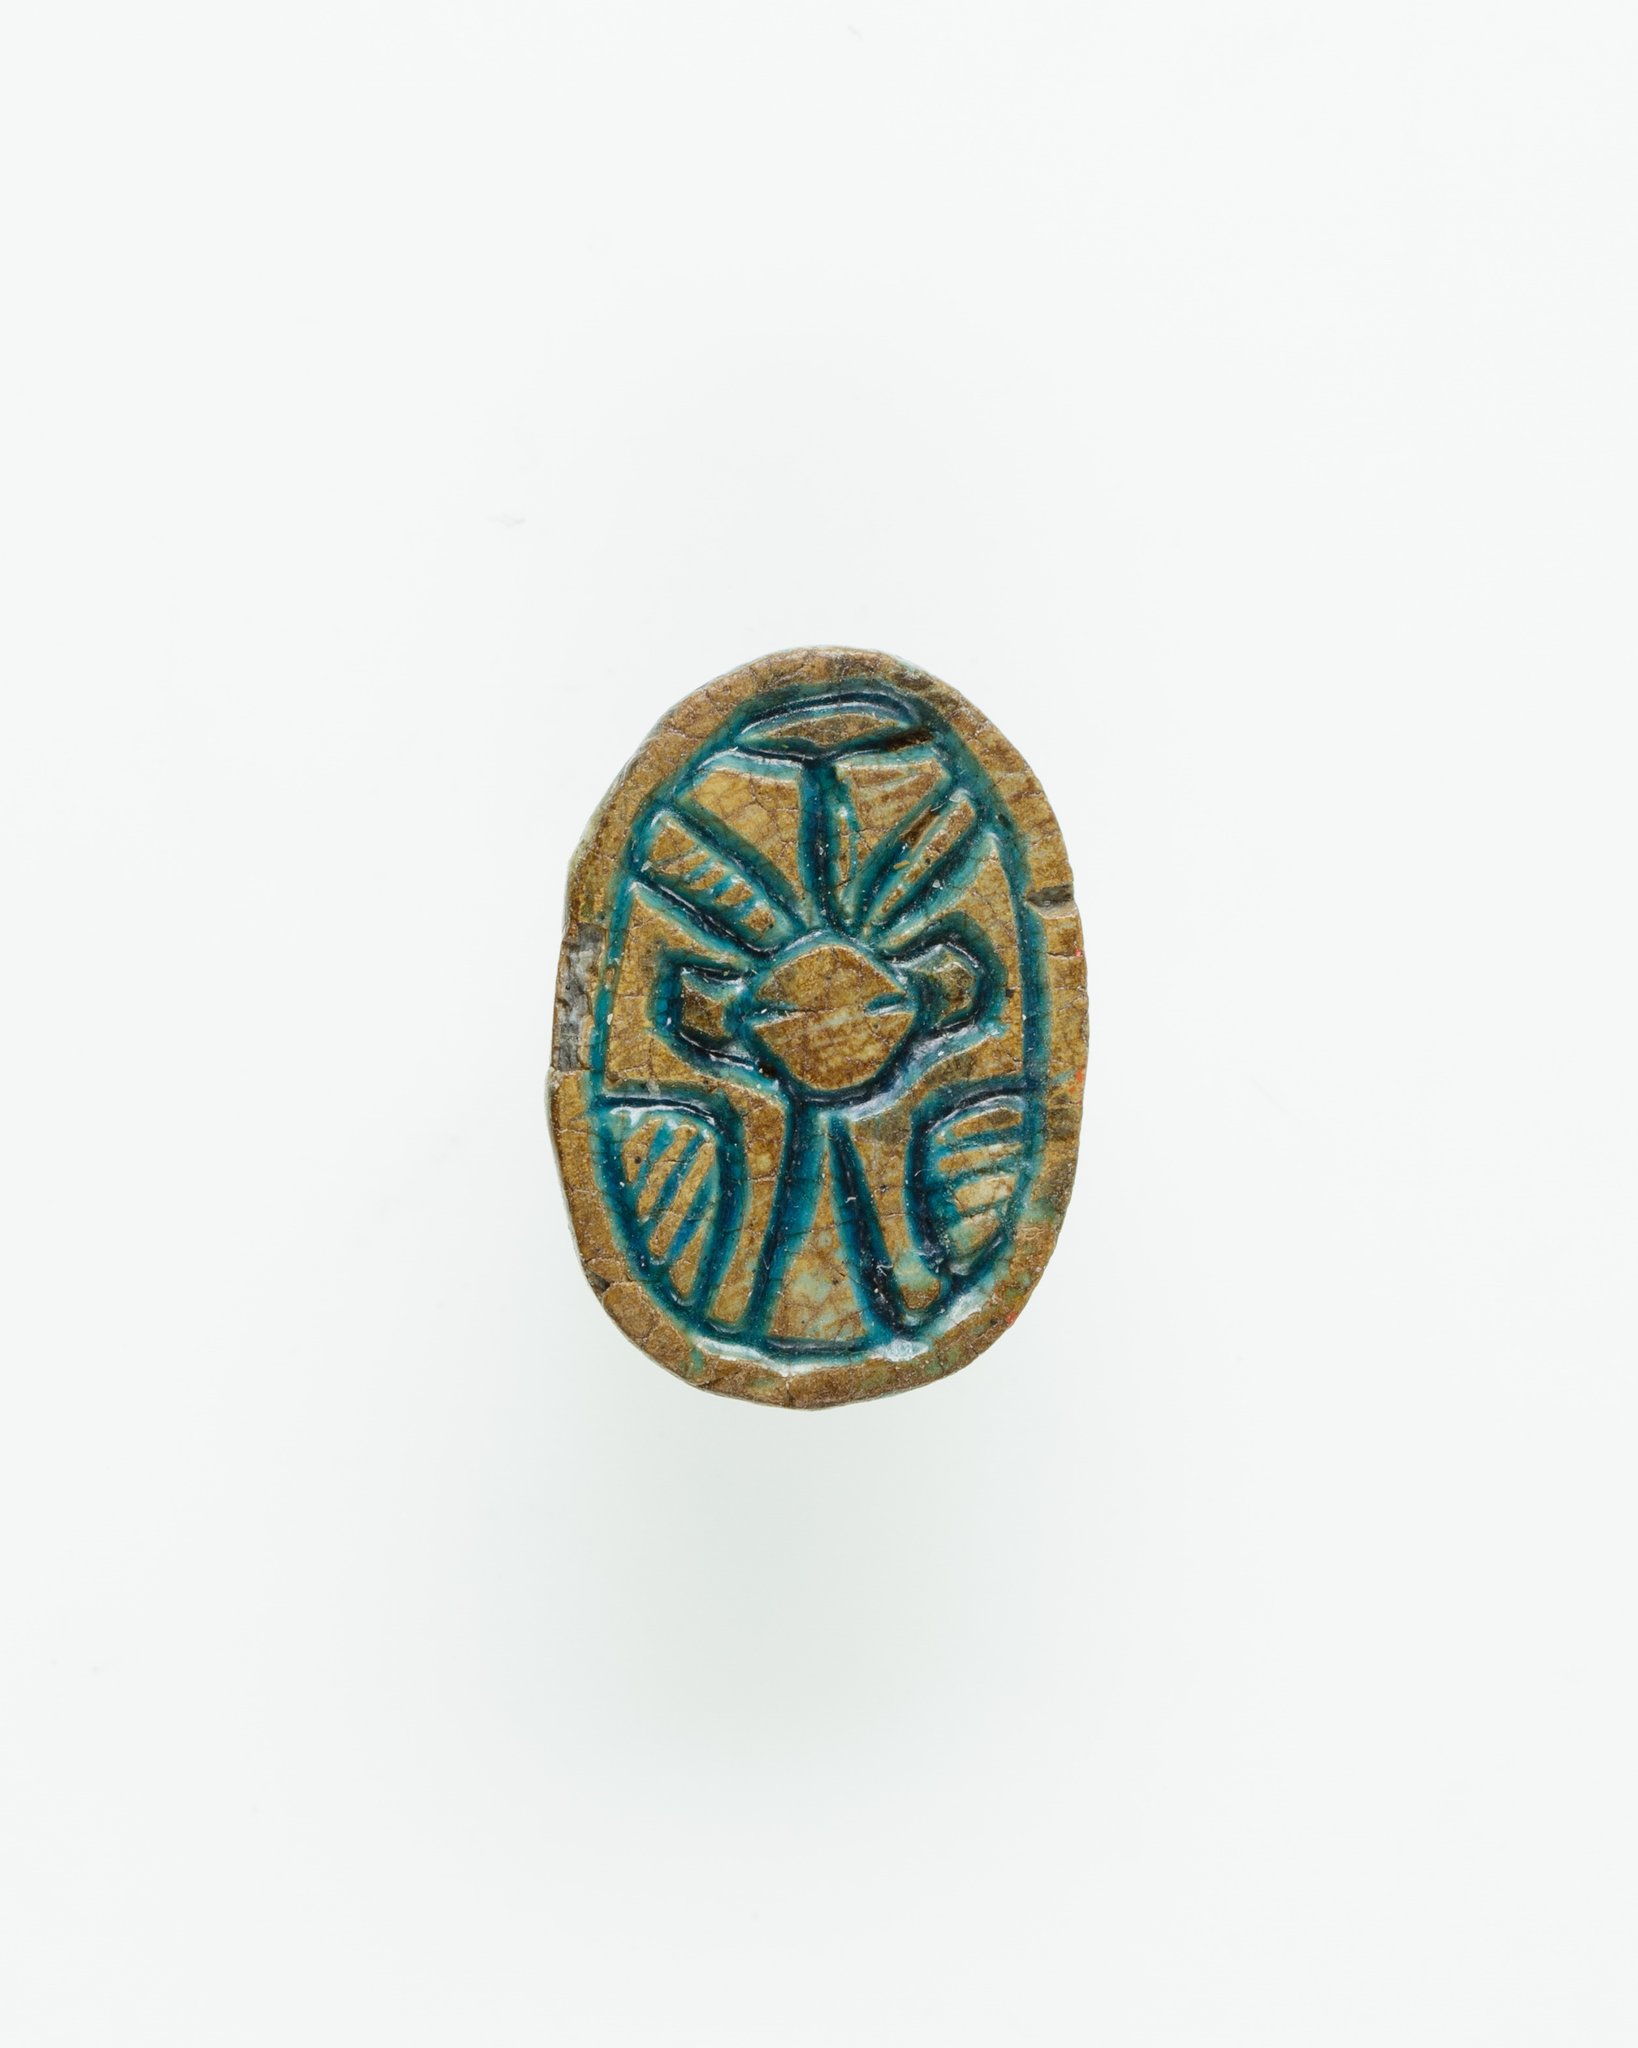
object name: scarab, canaanite goddess, 'hathor'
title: Scarab with Hathor-like Canaanite Goddess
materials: stone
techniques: glazing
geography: egypt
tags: scarabs